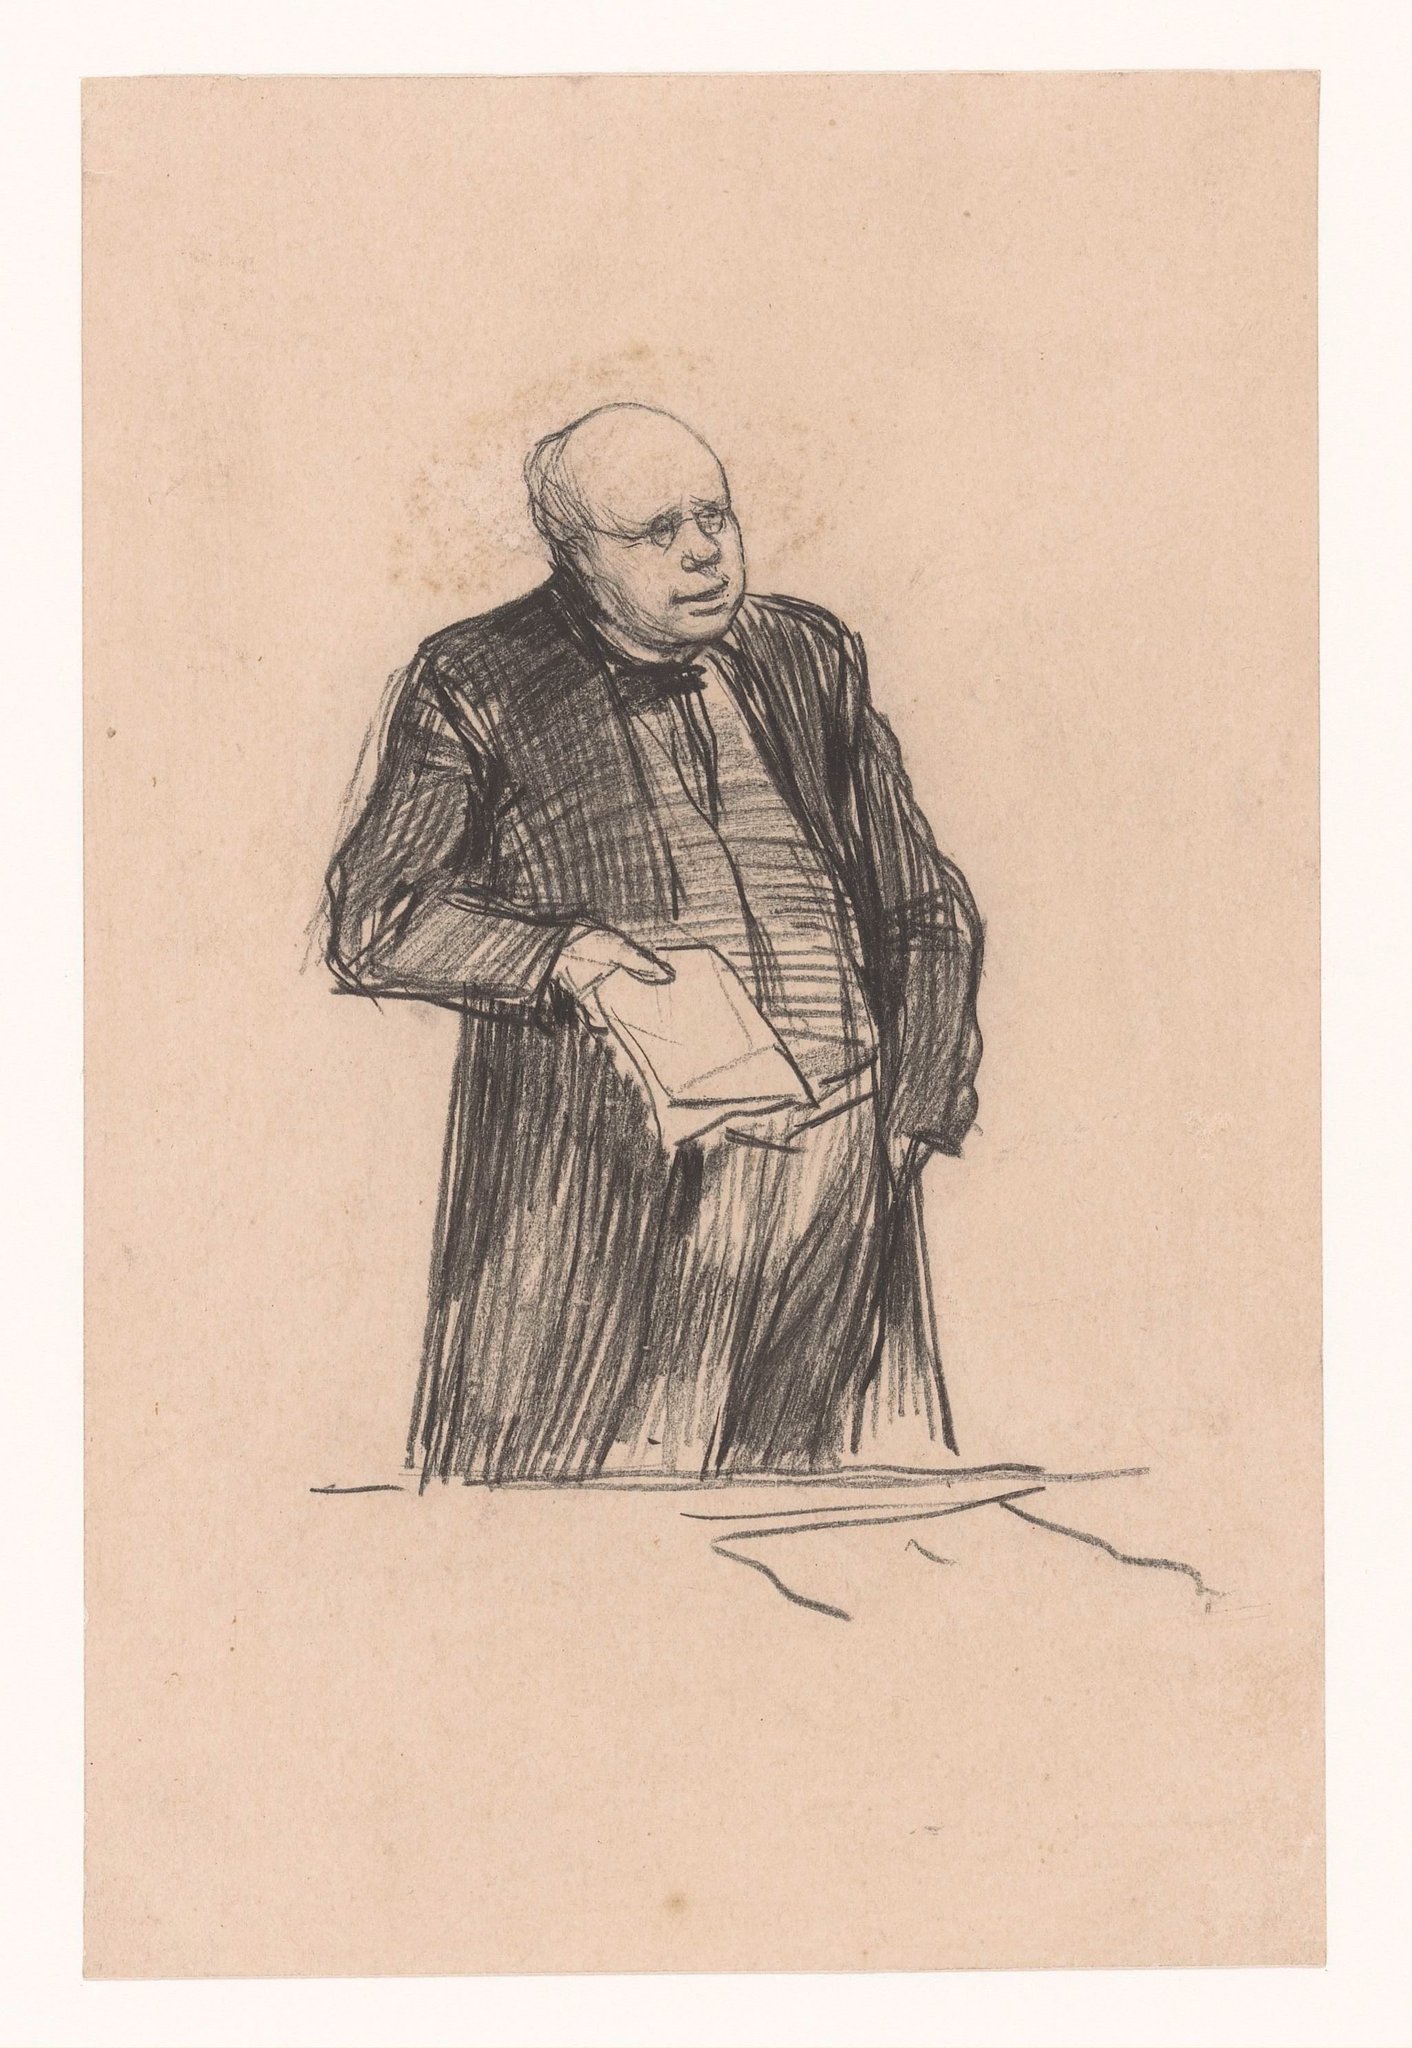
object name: drawing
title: Dr. Schaepman in de Tweede Kamer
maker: pieter de josselin de jong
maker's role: draughtsman, painter, print maker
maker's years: 1861-1906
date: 1887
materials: chalk, ink, paper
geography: the hague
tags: rome, priest, herman johannes aloysius maria schaepman, historical persons, politician, e.g. party leader, netherlands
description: Dr. Herman Schaepman tijdens de verdediging van zijn voorstel. Staand achter tafel met linkerhand in de broekzak, een blad papier in de rechterhand, kniestuk, lichtelijk naar rechts. Onderdeel van een groep schetsen van de bespreking in de Tweede Kamer van de grondwetsherziening van 1887 gepubliceerd in het weekblad Eigen Haard (1887).